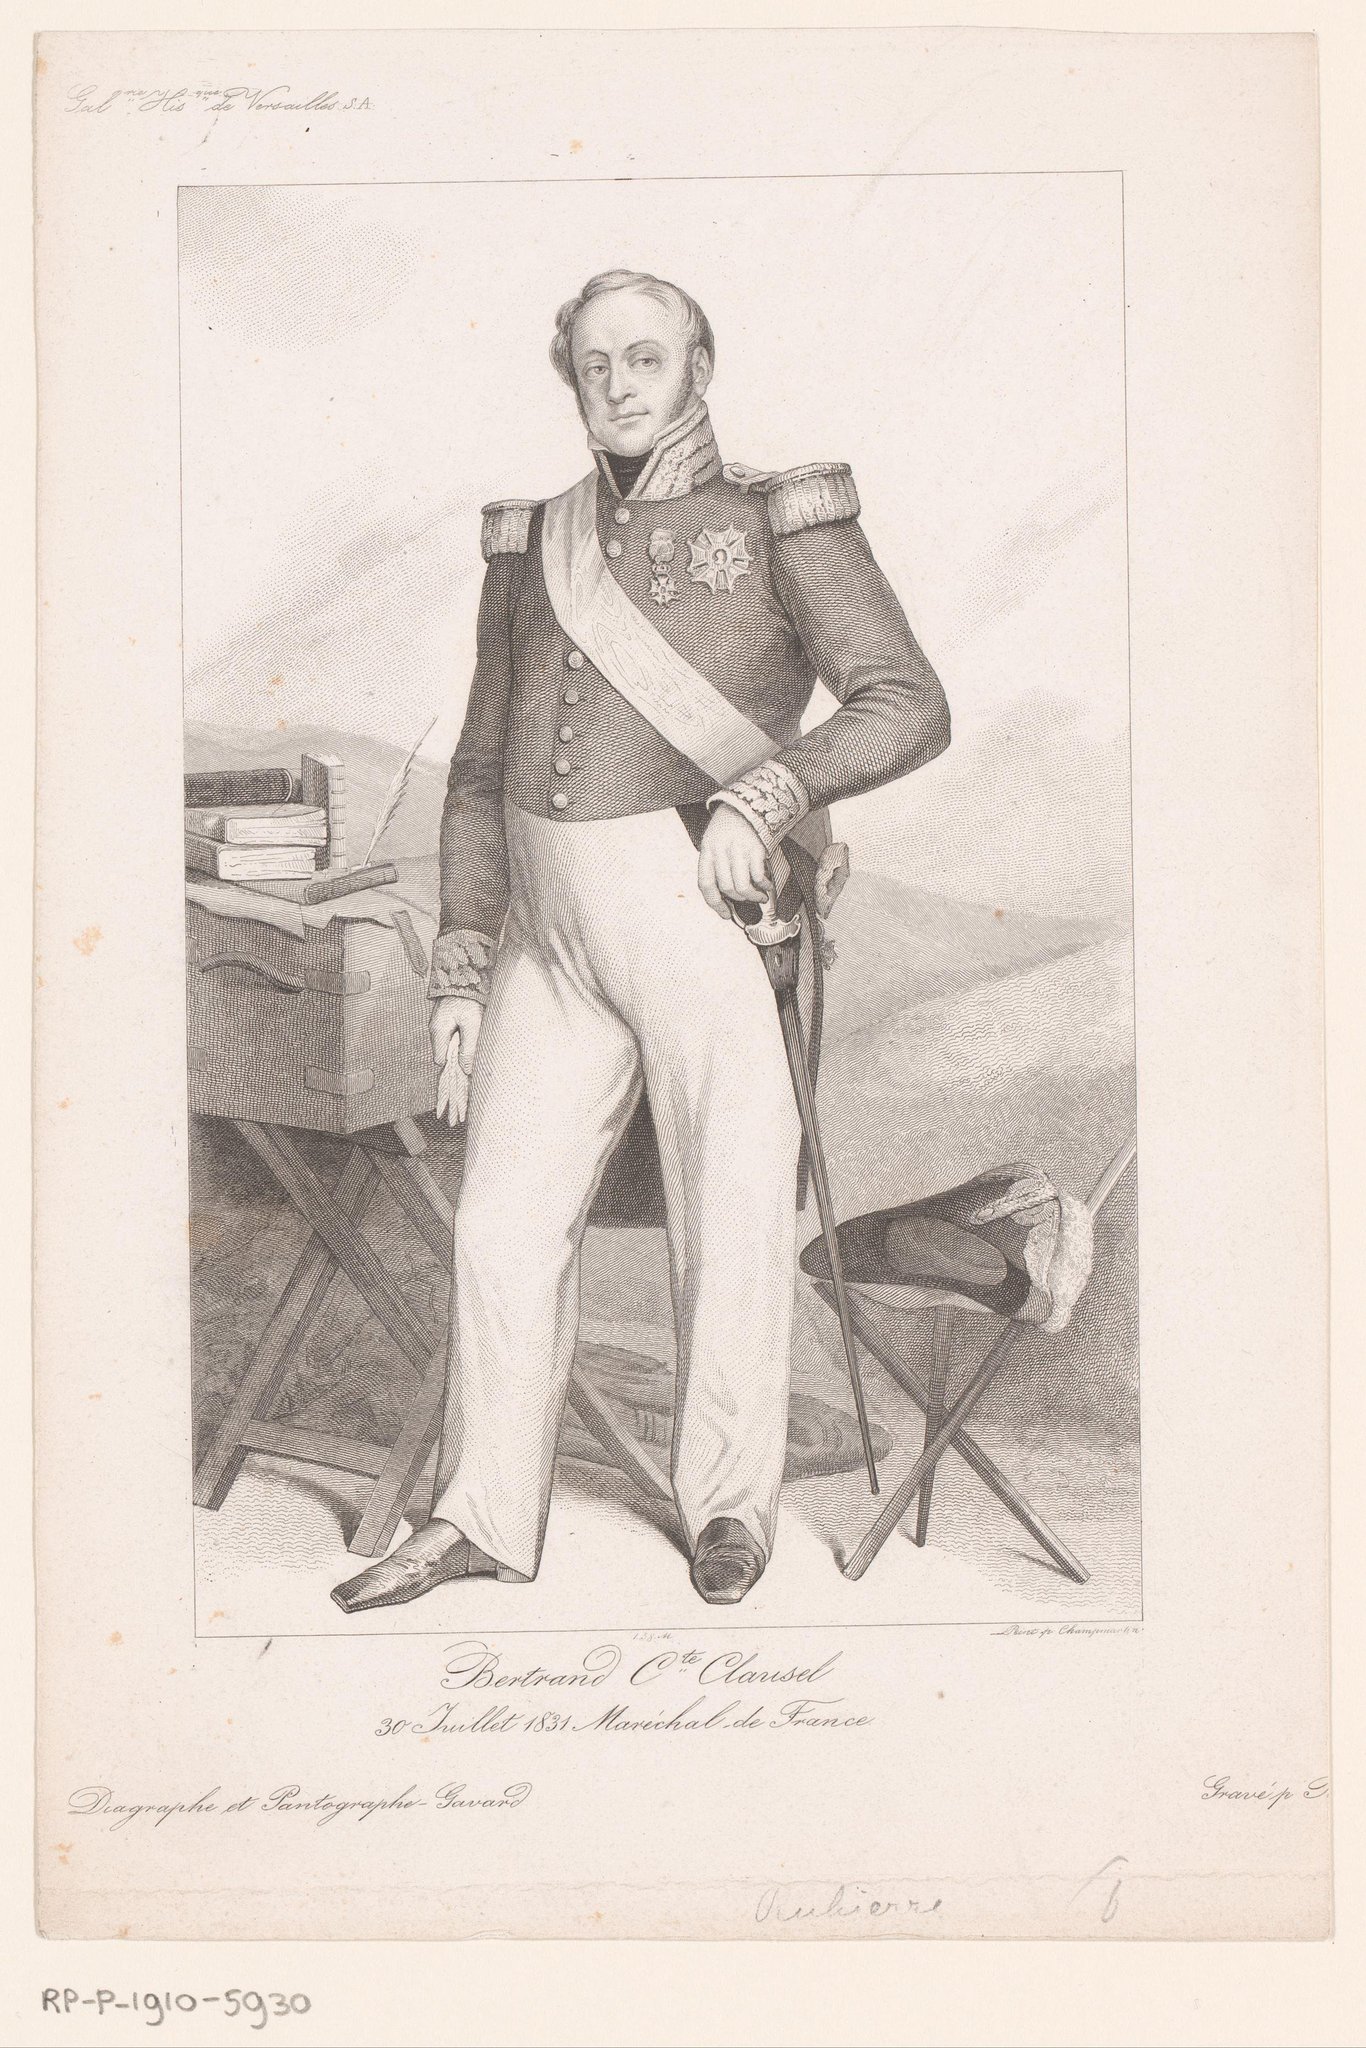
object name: book illustration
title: Bertrand Cte Clausel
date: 1838-1841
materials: paper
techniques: etching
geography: paris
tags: commander-in-chief, general, marshal, historical persons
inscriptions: collector's mark: Lugt 2228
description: Prent uit: s.n. Galeries historiques de Versailles. Parijs: Charles Gavard, 1838-1841.